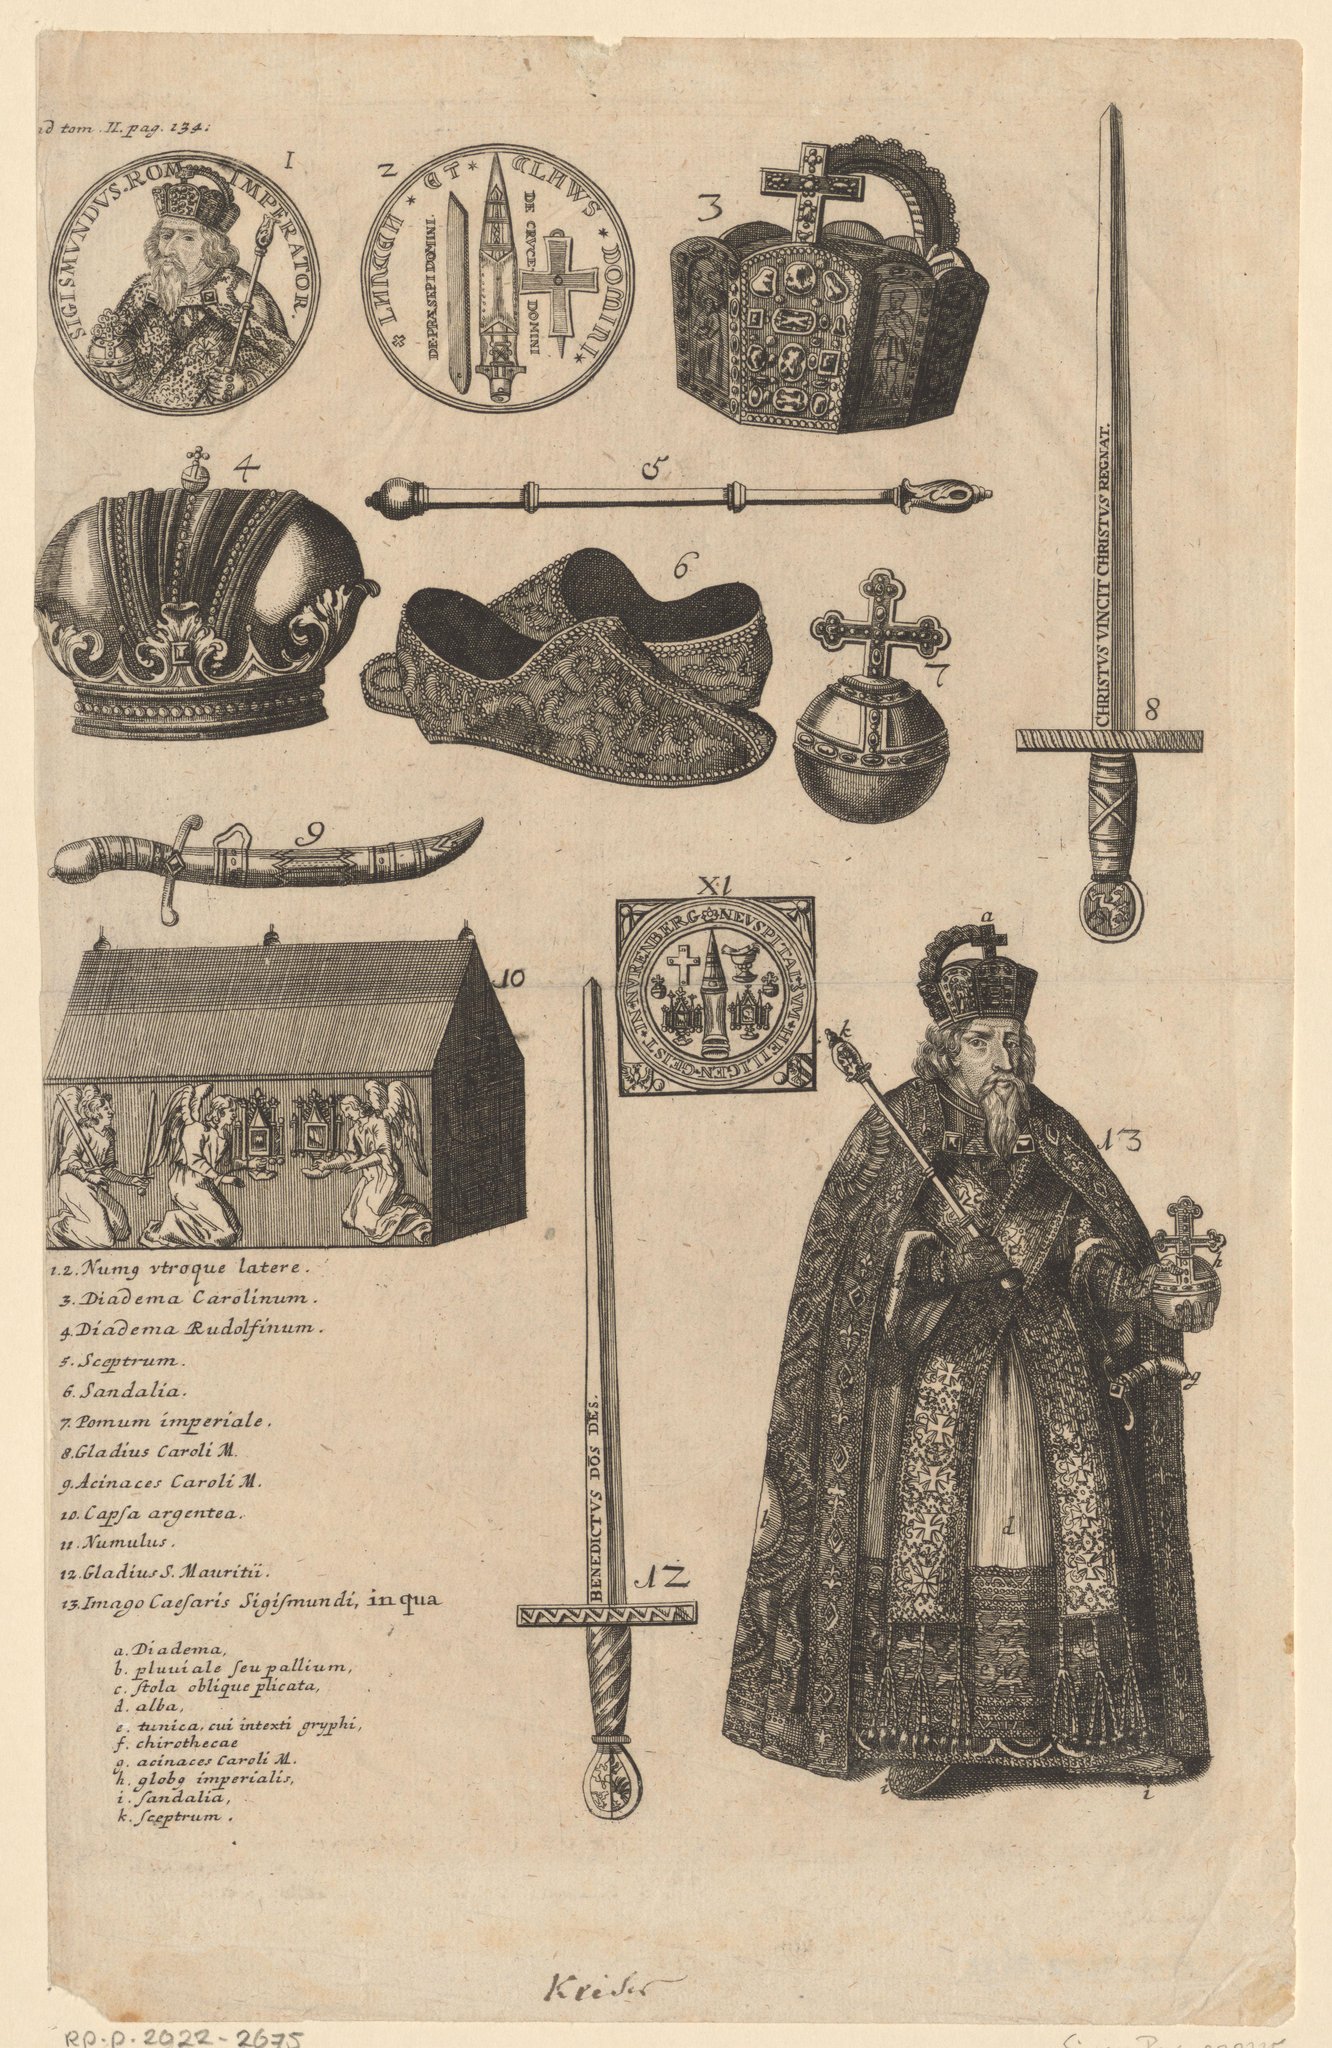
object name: print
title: Portret van Sigismund I met attributen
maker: Anonymous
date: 1720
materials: paper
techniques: etching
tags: historical persons, emperor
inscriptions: inscription: ‘Keiser’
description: Prent waarschijnlijk uit: Ludewig, Johann Peter von. Opuscula Miscella. Maagdenburg: Novi Bibliopolii, 1720.